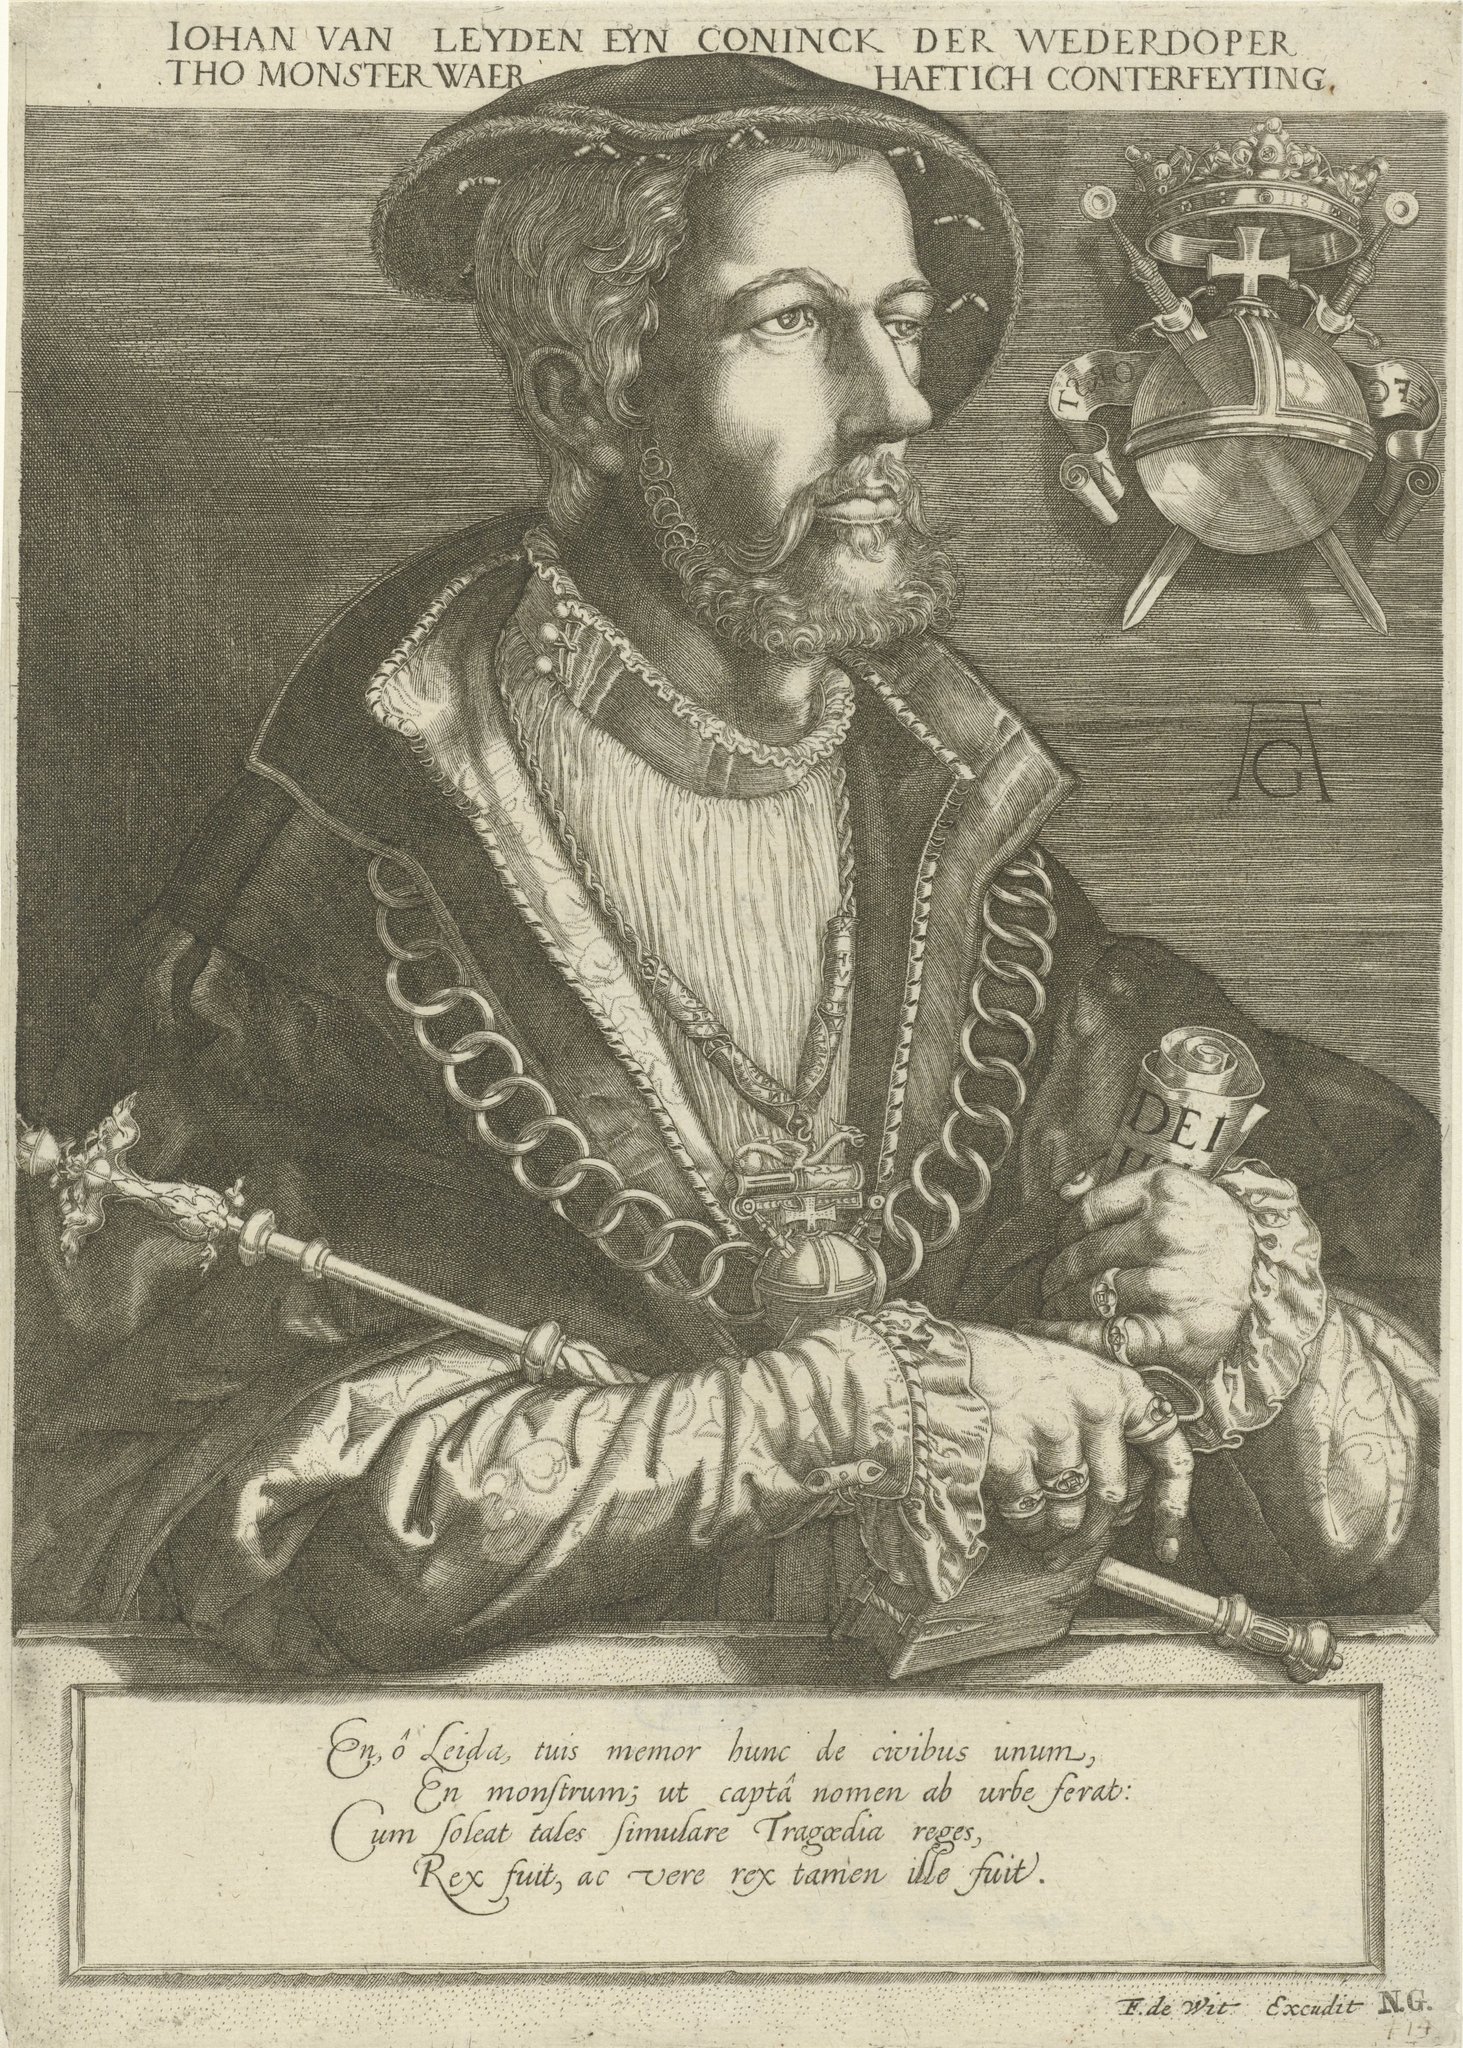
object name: print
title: Portret van Jan Beukelszoon van Leiden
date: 1613-1617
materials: paper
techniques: engraving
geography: amsterdam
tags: leiden, orb (symbol of sovereignty; sphere with cross on top), sceptre, staff (symbol of sovereignty)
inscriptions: collector's mark: Lugt 1967, collector's mark: Lugt 2228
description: Portret van Jan Beukelszoon van Leiden, leider en zelfuitgeroepen koning van de wederdopers in Münster. Om zijn hals een ketting, onder de arm een scepter en in zijn handen een bijbel en een pamflet. Rechtsboven een gekroonde rijksappel, doorboord met twee zwaarden. Onderaan een vierregelig vers in het Latijn.